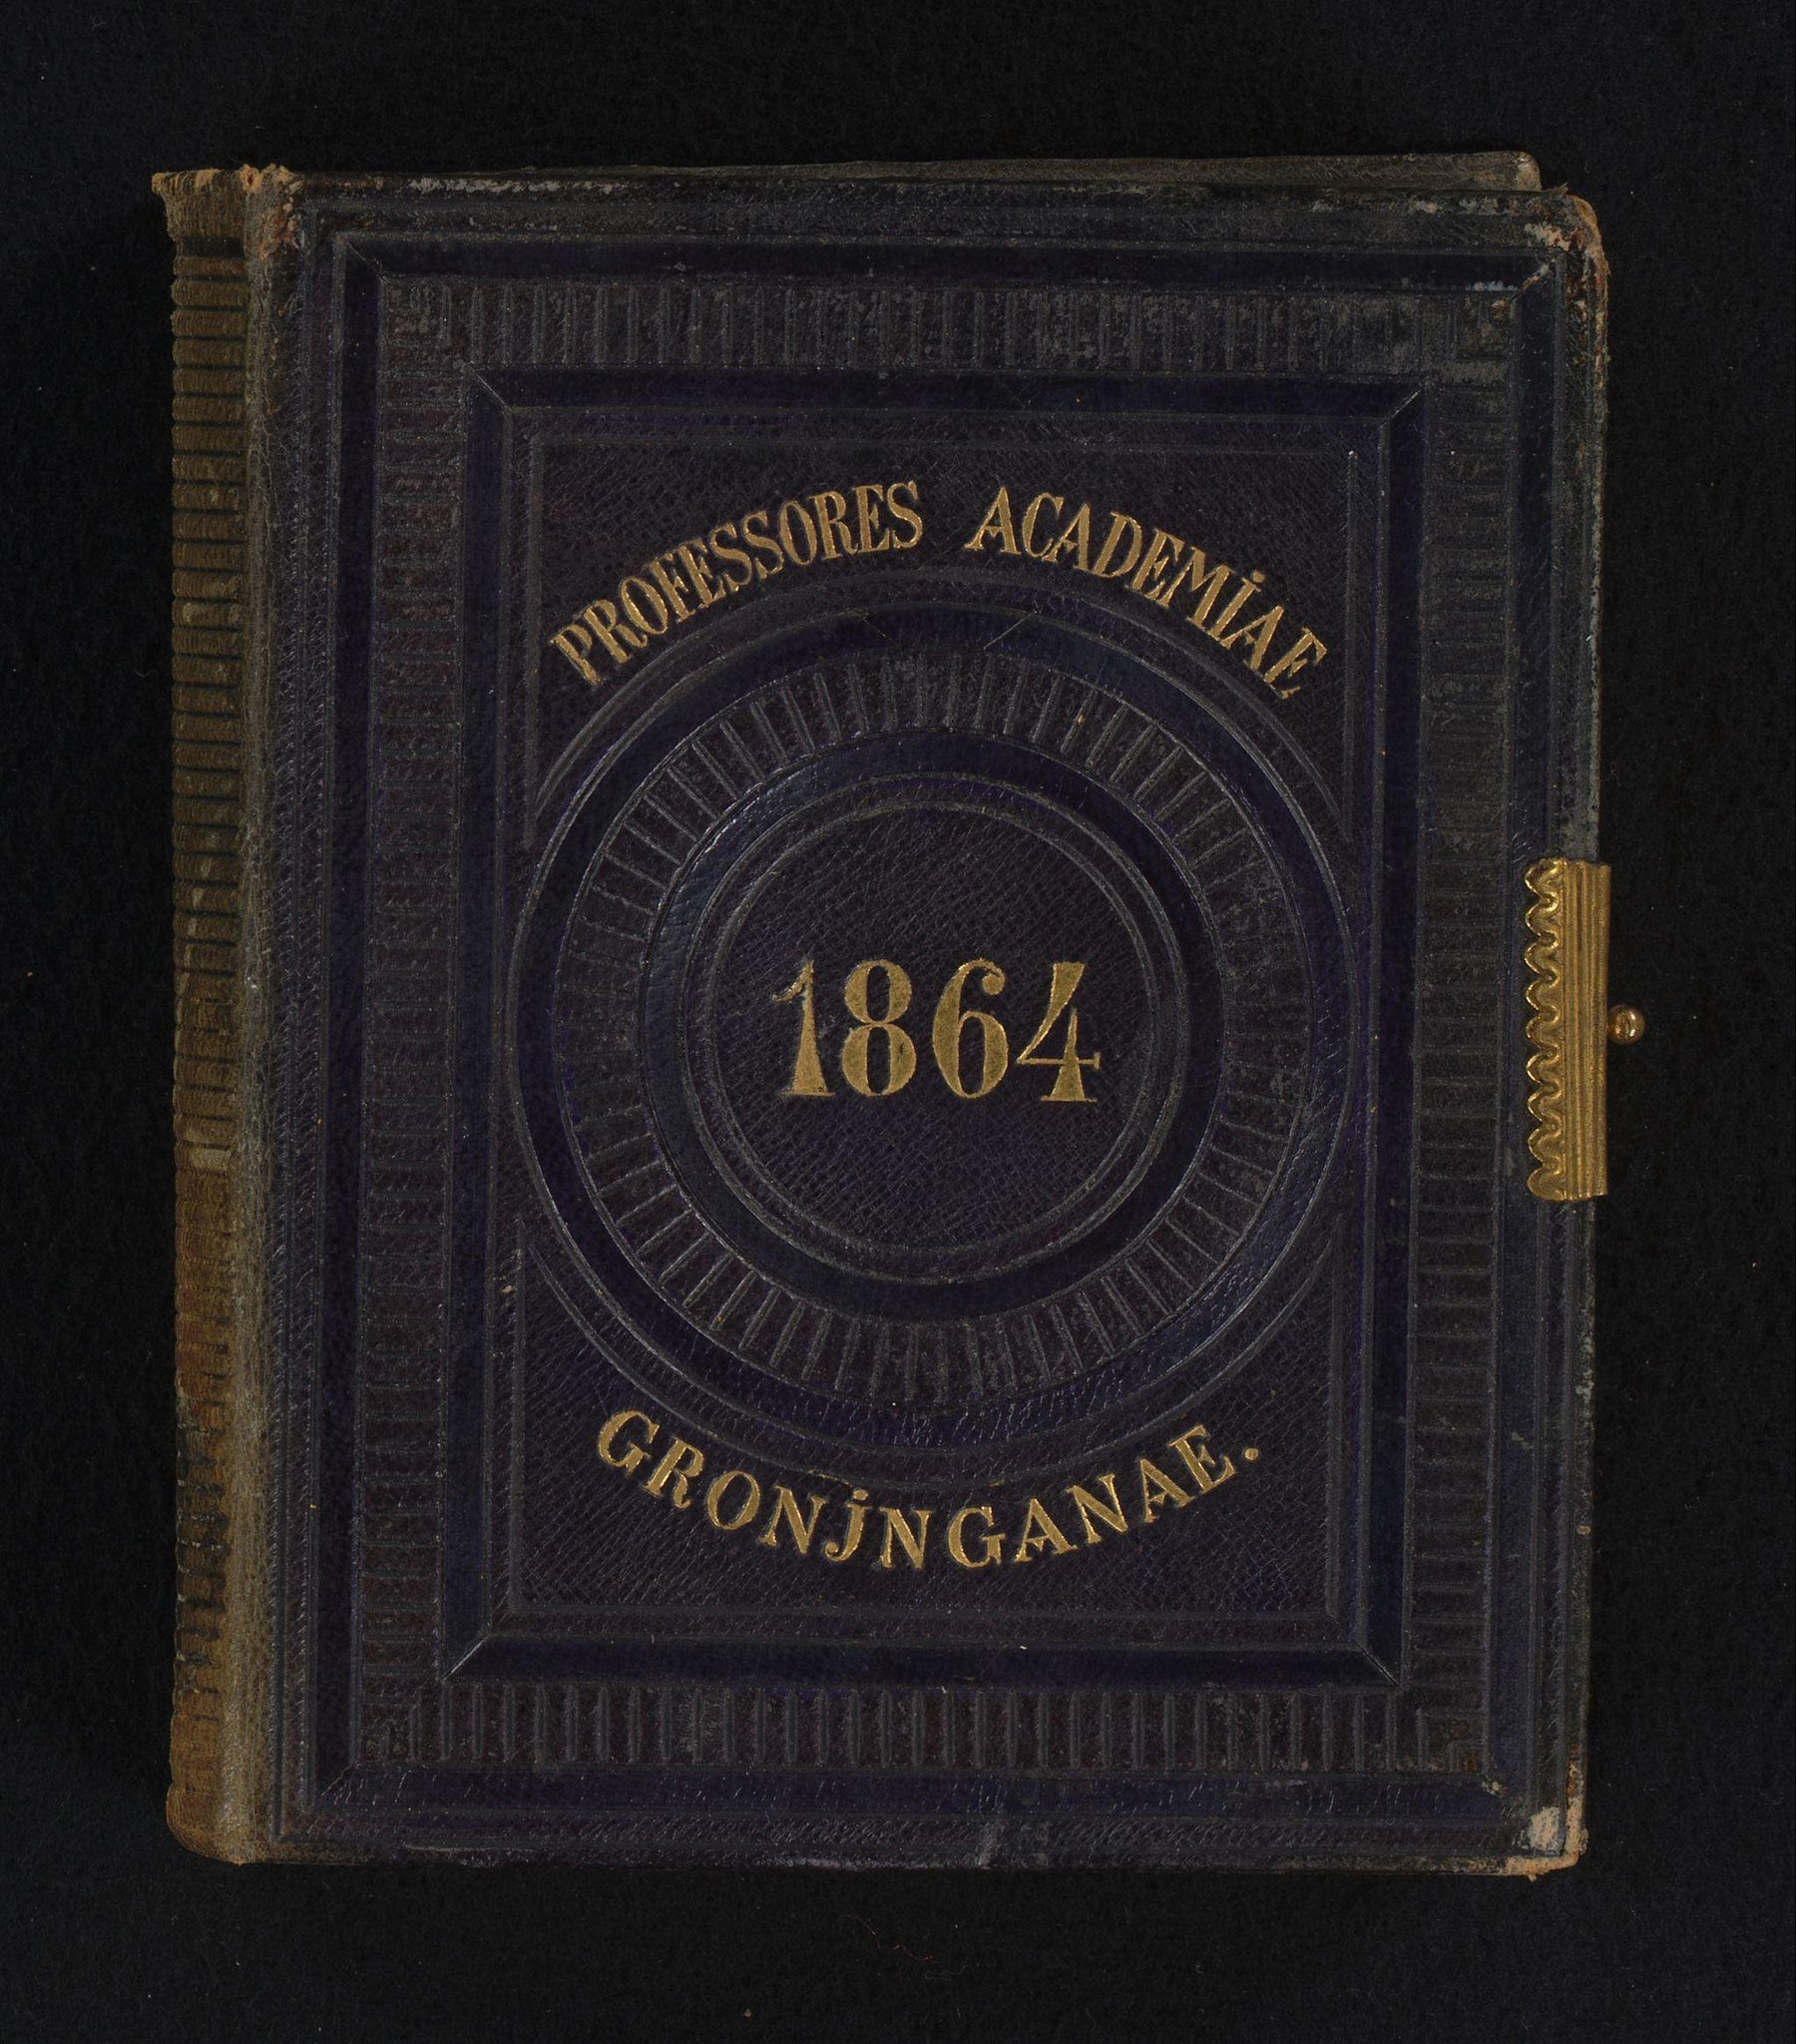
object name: slip in album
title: Fotoalbum met portretten op carte-de-visite-formaat van Groningse hoogleraren in 1864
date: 1864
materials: brass, cardboard, leather, paper, photographic support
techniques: albumen print, gilding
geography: groningen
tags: amsterdam, middelburg, delft, the hague, willem august hecker, professor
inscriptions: inscription: ‘Professores academiae gro-/ ninganae. 1864._/ Wijsbegeerte en Letteren./ 1. W.J.A. Jonckbloet./ 2. J.J.P. Valeton./ 3. W. Hecker./ 4. C.M. Francken./ 5. B.H.C.K. Van der Wijck./ Regtsgeleerdheid./ 6. J.H. Philipse./ 7. B.J. Gratama./ 8. B.D.H. Tellegen./ 9. G. Diephuis./ Geneeskunde./ 10. F.Z. Ermerins./ 11. J. Baart de la Faille./ 12. J. Hissink Jansen./ 13. J. Van Deen./ Wis- en natuurkunde./ 14. H.P. Van Hall./ 15. J.W. Ermerins./ 16. P.J. Van Kerckhoff./ 17. C. Mulder./ 18. W.A. Enschedé./ Godgeleerdheid./ 19. P.Hofstede de Groot./ 20. L.G. Pareau./ 21. W. Muurling./ 22. E.J. Diest Lorgion.’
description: Fotoalbum met 22 fotografische portretten op carte-de-visite-formaat van Groningse hoogleraren in 1864.